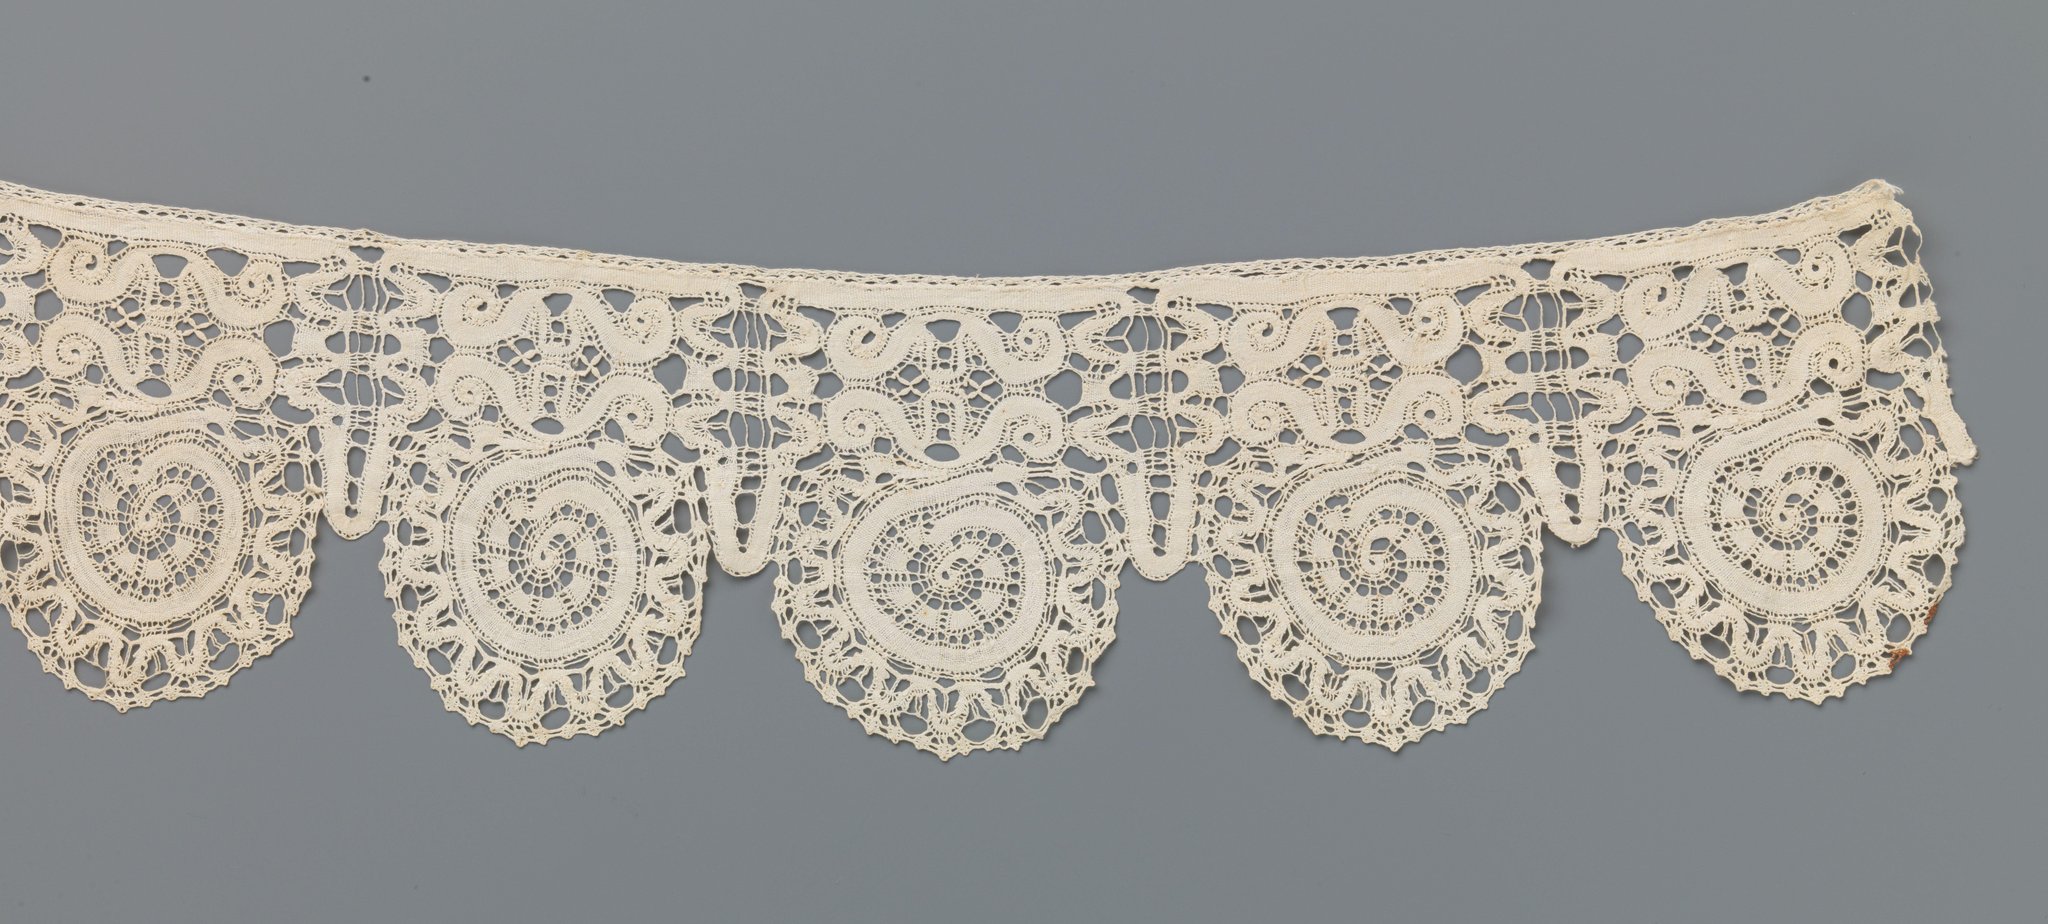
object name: strip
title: Strook kloskant met spiraal en gespiegelde voluten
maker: Anonymous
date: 1600-1649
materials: linen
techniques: lace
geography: flanders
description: Strook naturelkleurige kloskant: oudvlaamse kloskant. Het zich herhalende patroon bestaat uit een dubbele voluut, die over de breedte-as gespiegeld is en daaronder een halfronde schulp, die gevormd wordt door een spiraal. De motieven zijn gevormd door gekloste linten, gemaakt in linnenslag met opengewerkte randjes. De spiraal wordt door een regelmatig slingerend smaller lintje omringd. Tussen de gespiegelde voluten zijn kruisjes gemaakt met vormslagen. De motieven zijn door vlechtjes met elkaar verbonden. De bovenrand is afgewerkt met een apart geklost bandje.